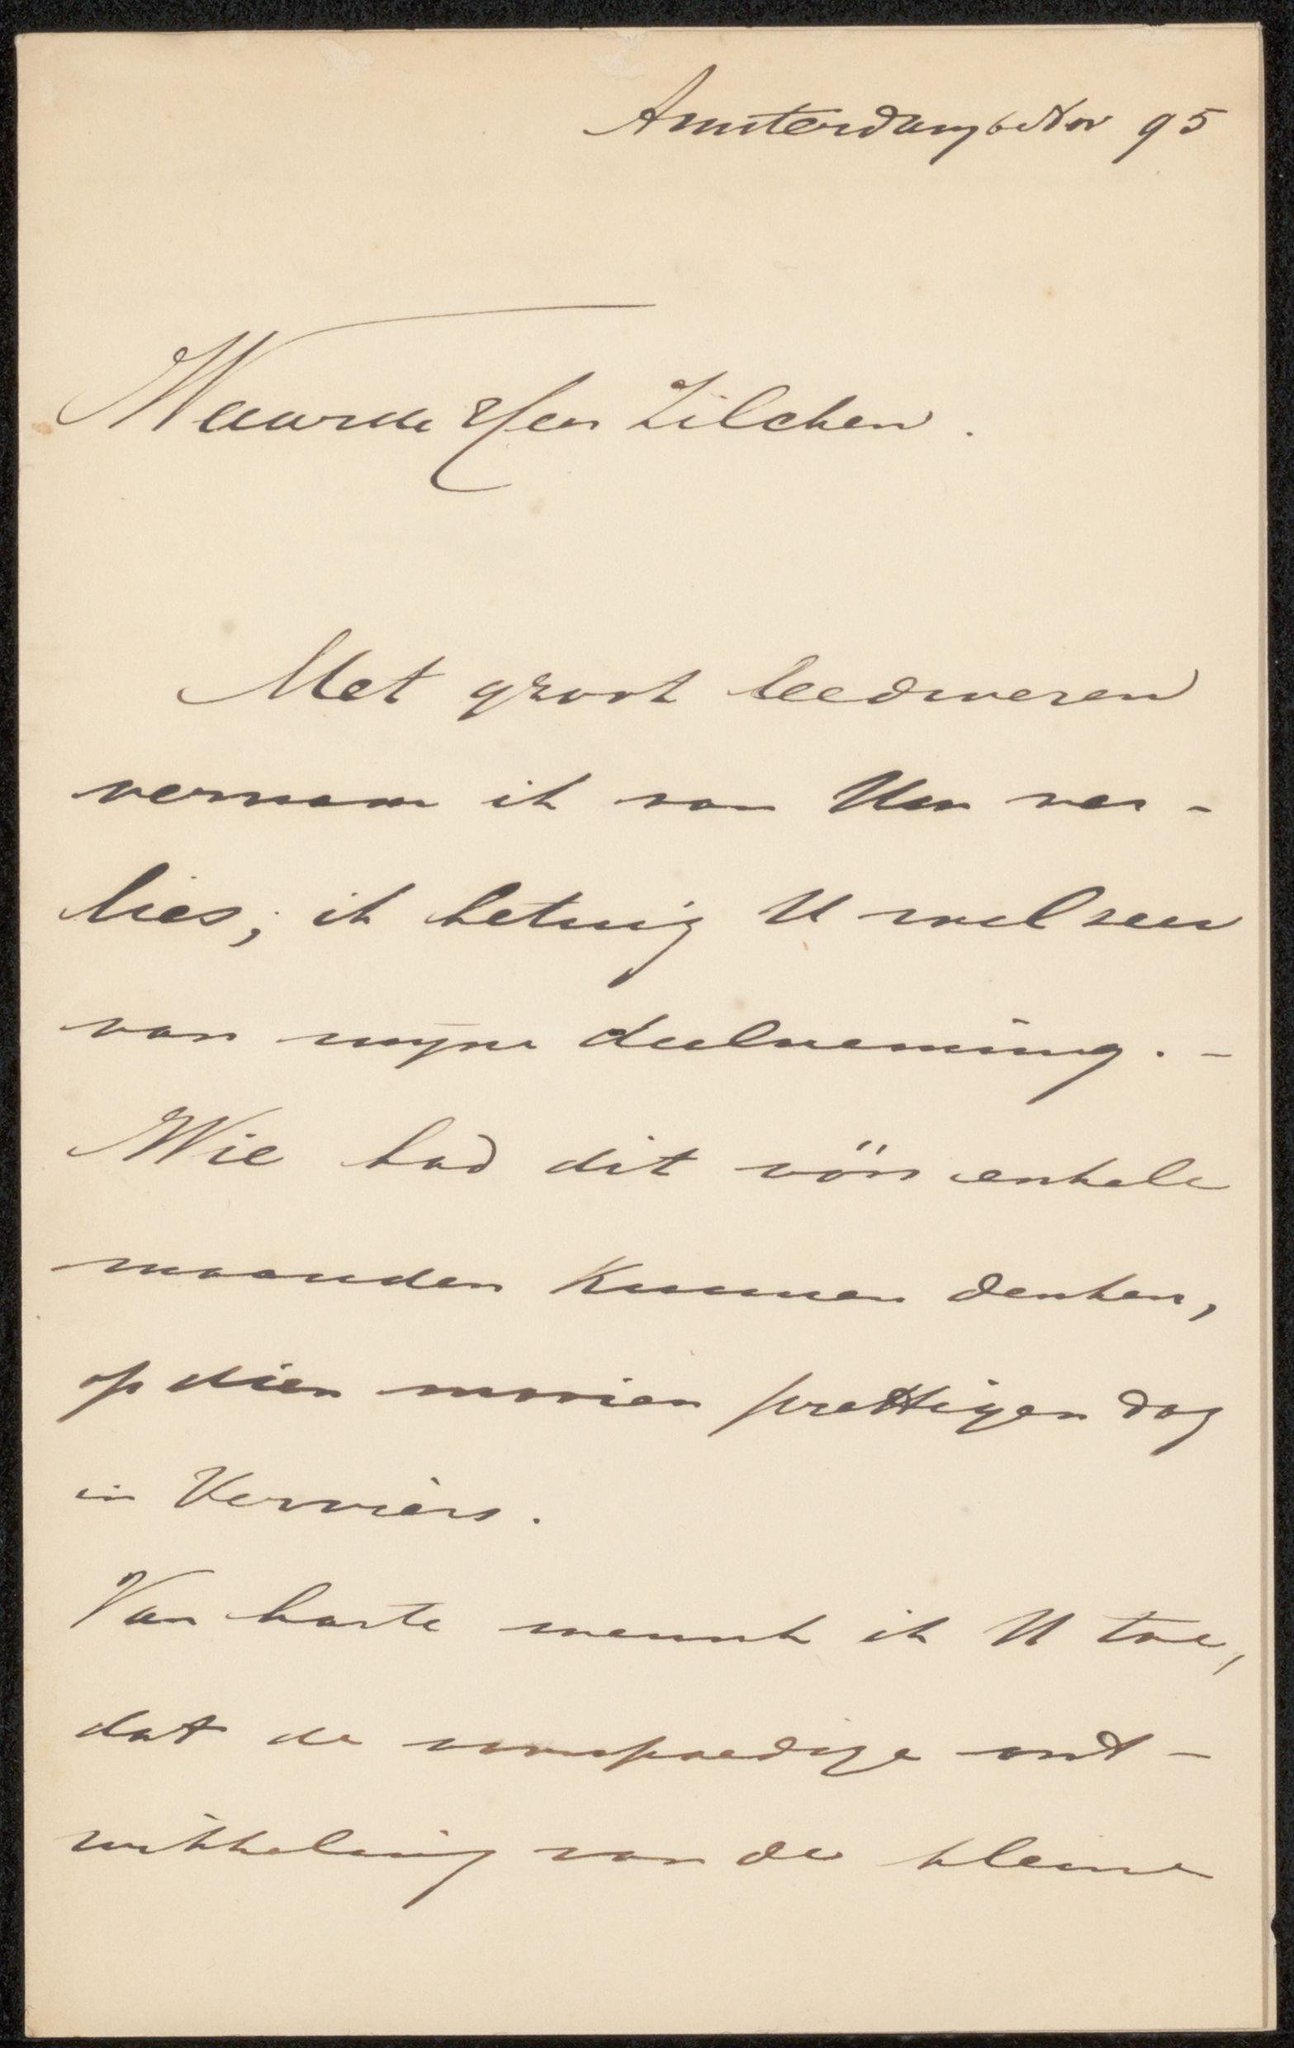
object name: letter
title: Brief aan Philip Zilcken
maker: klaas groesbeek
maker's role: boekhandelaar, kunsthandelaar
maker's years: 1858-1936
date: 1895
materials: ink, paper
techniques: pen, writing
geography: amsterdam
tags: voorburg, print maker, renée hélène laure zilcken, helène lambertine hauzeur, the hague, painter, draughtsman, philip zilcken, passions, emotions, affections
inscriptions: watermark